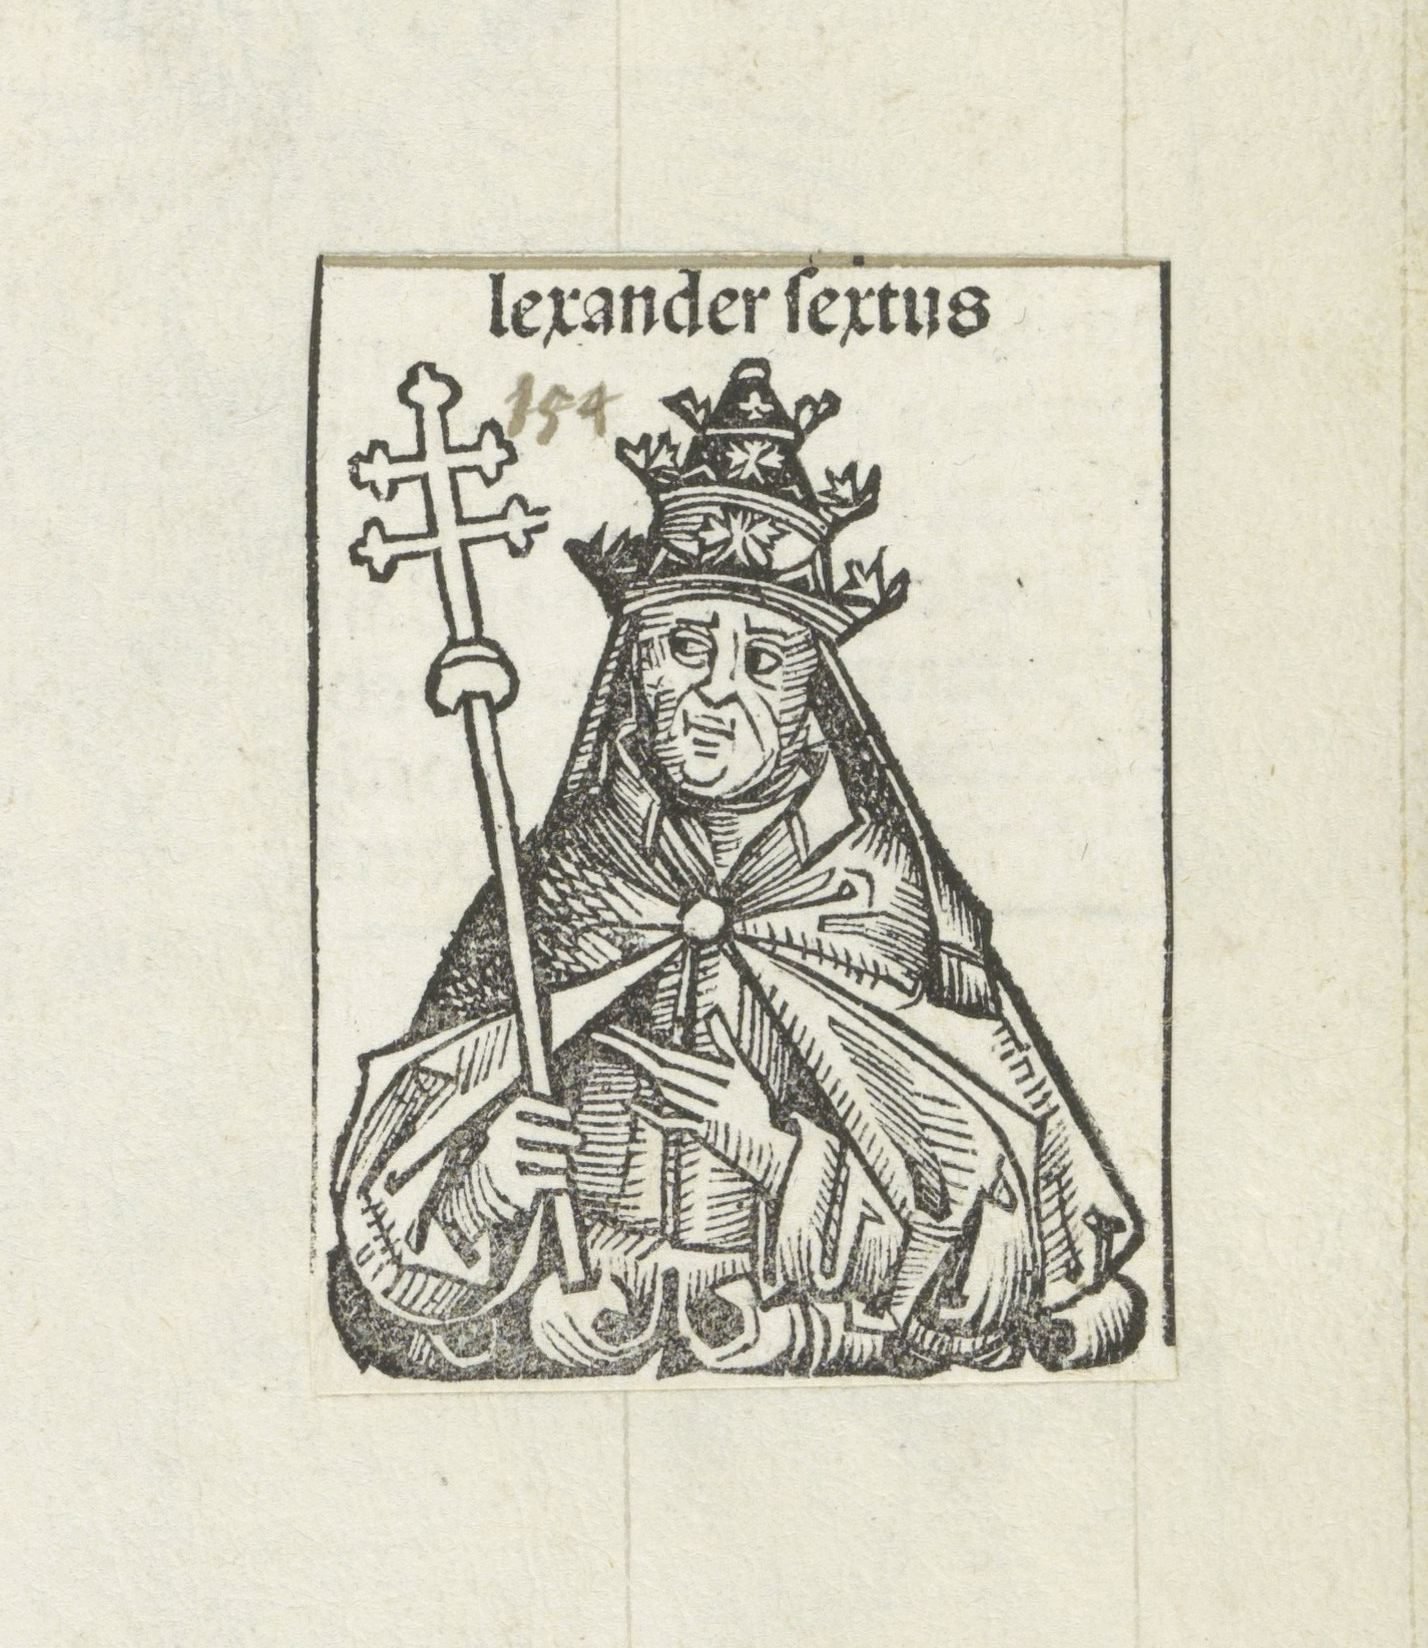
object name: print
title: Paus Alexander VI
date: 1493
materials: paper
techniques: letterpress printing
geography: nuremberg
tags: pope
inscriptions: inscription: ‘154’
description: Een bloemkelk met een paus. Hij draagt een tiara en heeft een staf met dubbel kruis in zijn handen. De voorstelling is onderdeel van de opeenvolging pausen in de Liber Chronicarum. De tekst identificeert de man als Alexander VI. De prent maakt deel uit van een album.